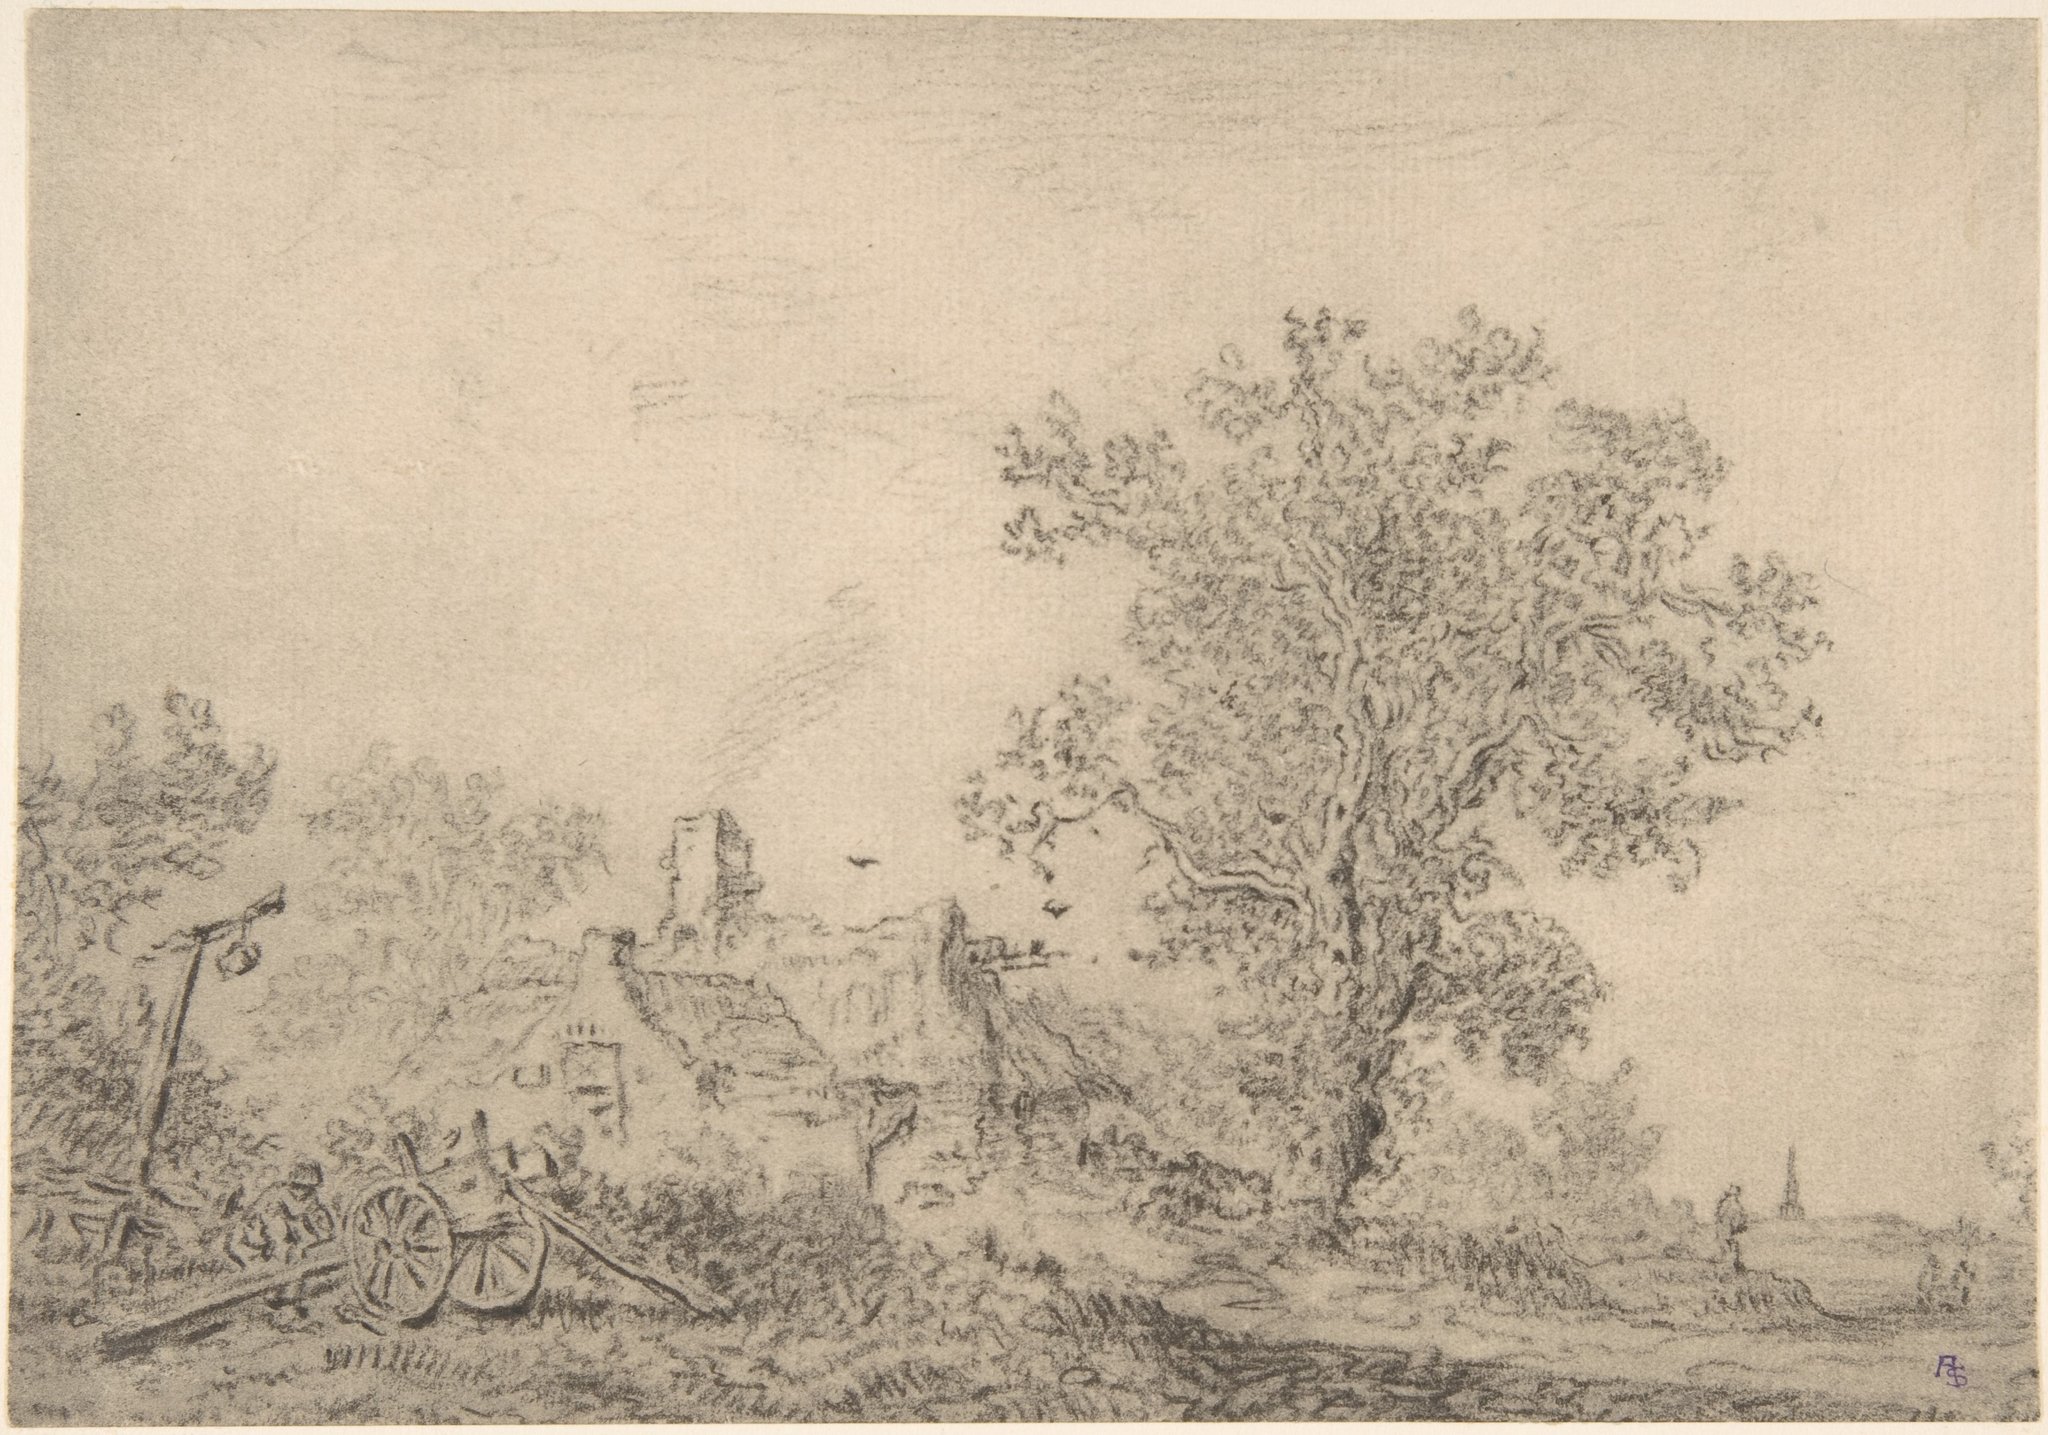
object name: drawing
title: Landscape with cottages and a figure by a cart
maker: pieter de molijn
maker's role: artist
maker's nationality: dutch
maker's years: 1595-1661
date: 1601-1700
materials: chalk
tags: houses,landscapes,trees